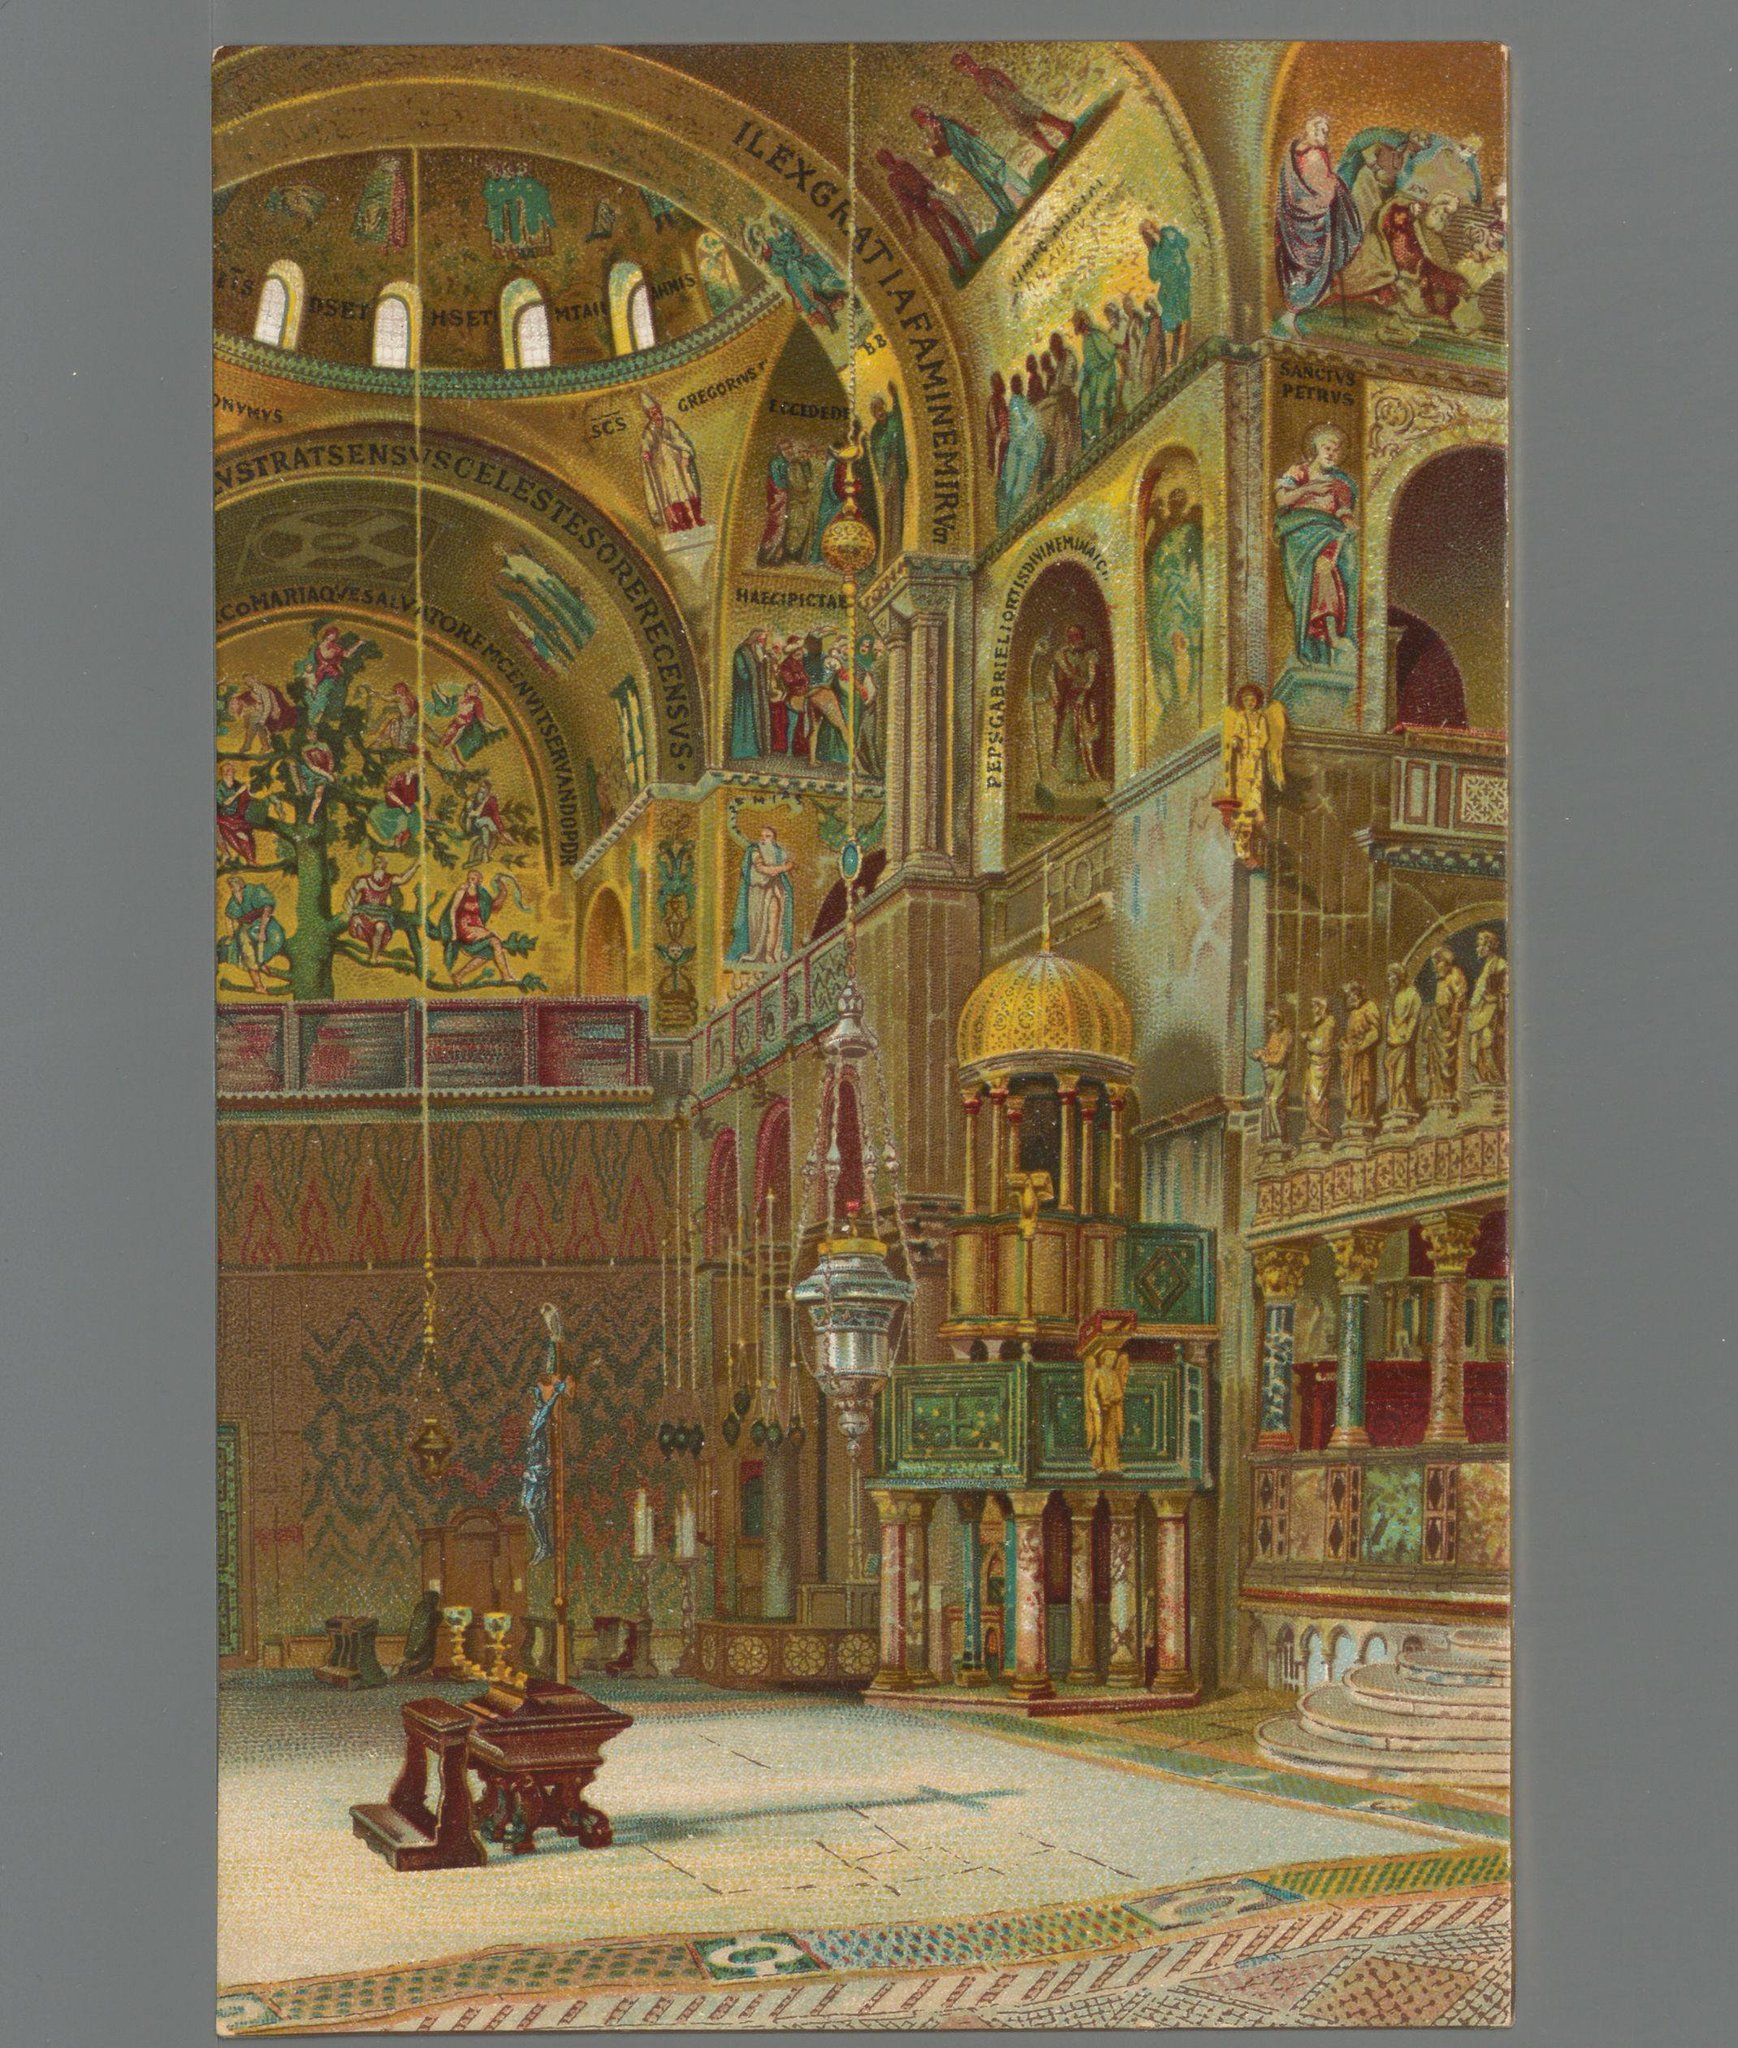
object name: reproduction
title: Basilica di S. Marco in Venezia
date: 1906-1920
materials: cardboard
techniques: lithograph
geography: venice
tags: the monumental arts, interior of church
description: Oorspronkelijke prent uit: La Basilica di San Marco in Venezia. Venetië: Ferdinando Ongania, 1881-1884. De oorspronkelijke prenten uit dit werk zijn gesigneerd.